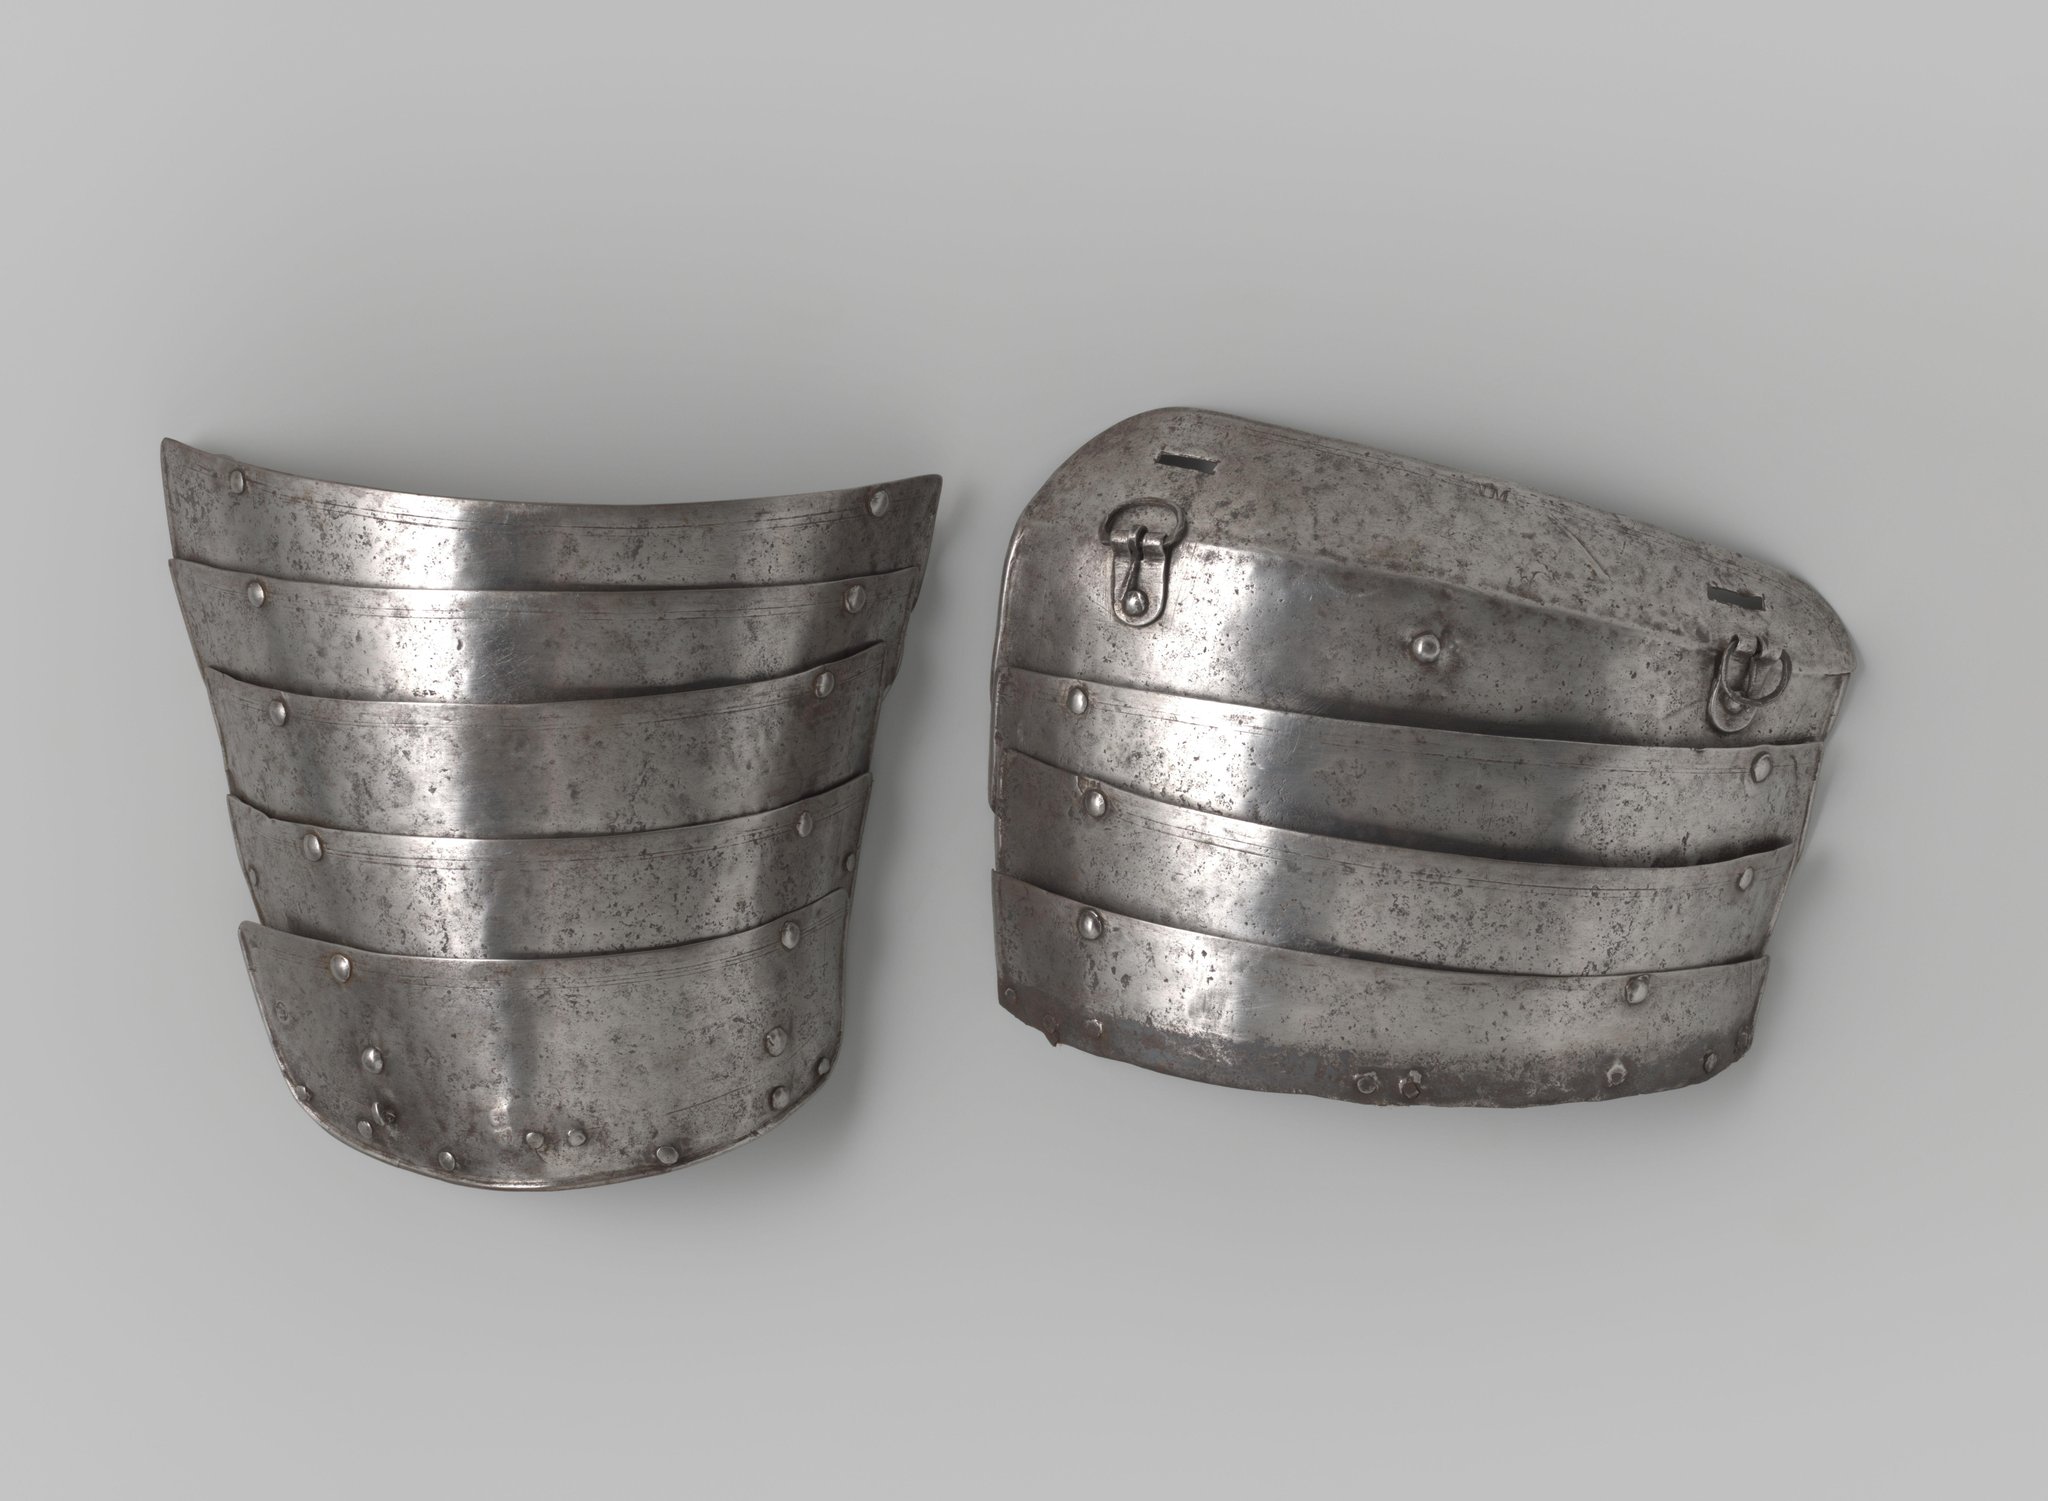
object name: beenplaat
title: Paar beenplaten behorend bij de wapenrusting, vermoedelijk gedragen door den ridder Pankraz von Freyberg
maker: Anonymous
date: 1500-1550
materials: iron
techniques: riveted, striking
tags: beieren, pankraz von freyberg, kasteel hohenaschau